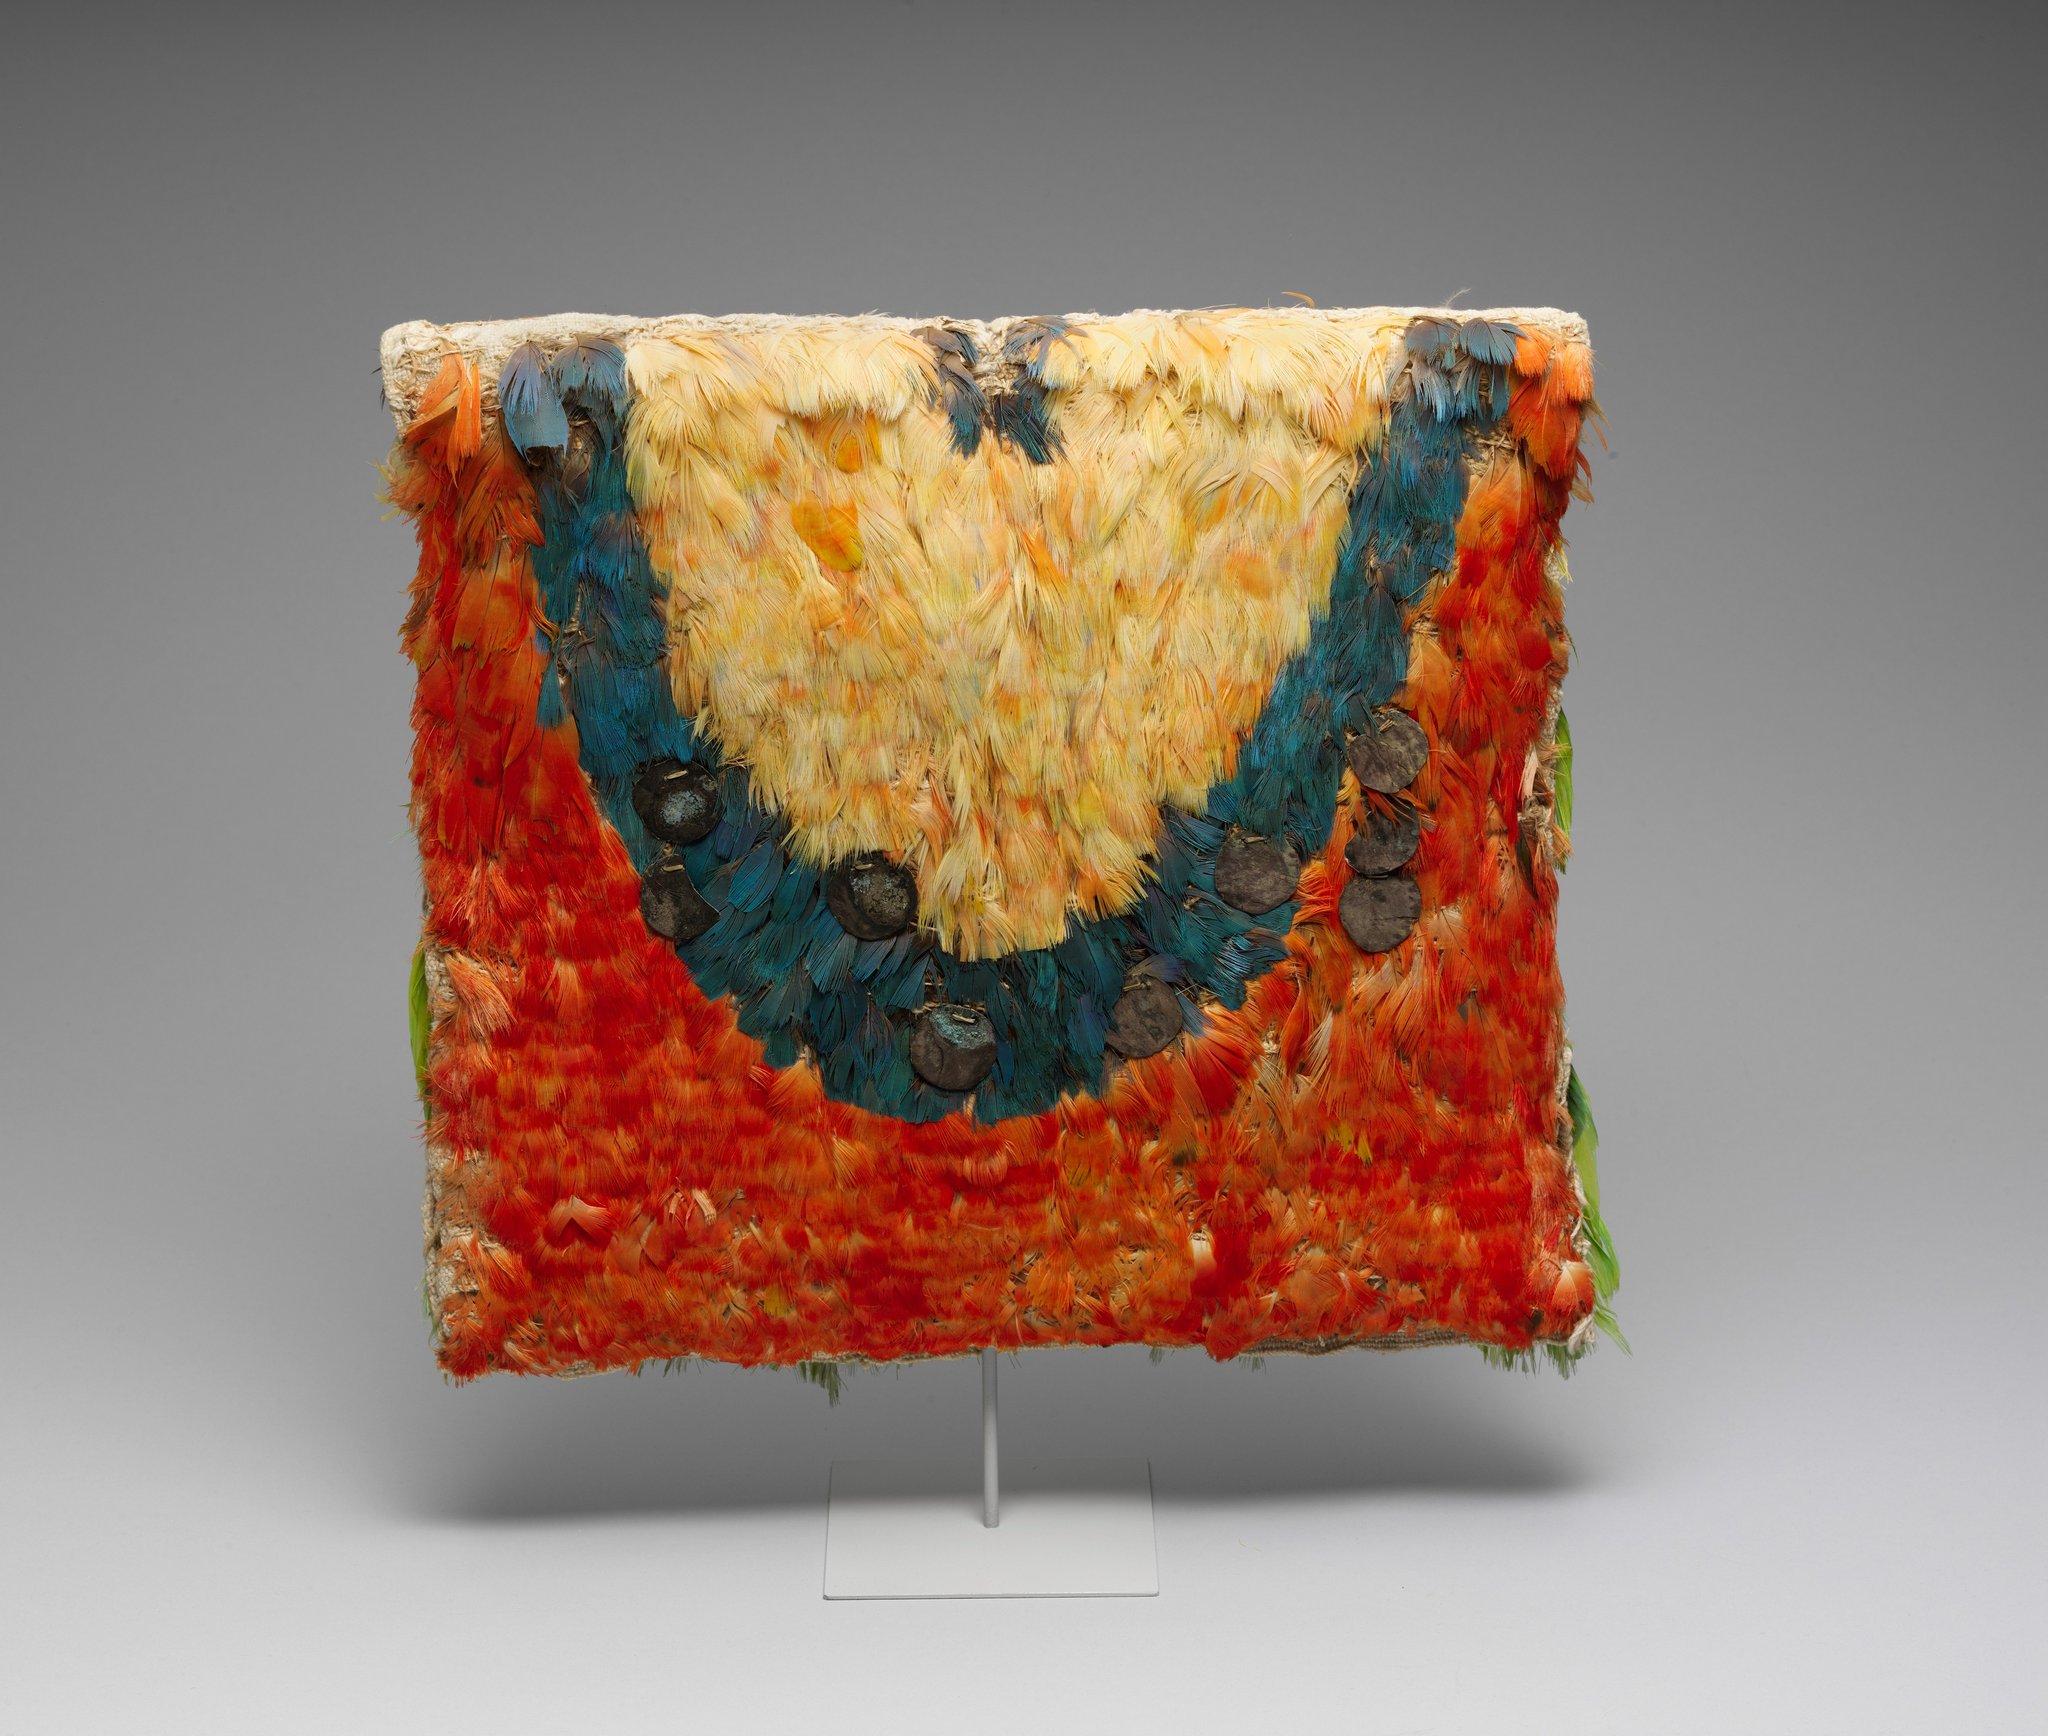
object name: miniature tunic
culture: ica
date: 1101-1300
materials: cotton, feather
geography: peru